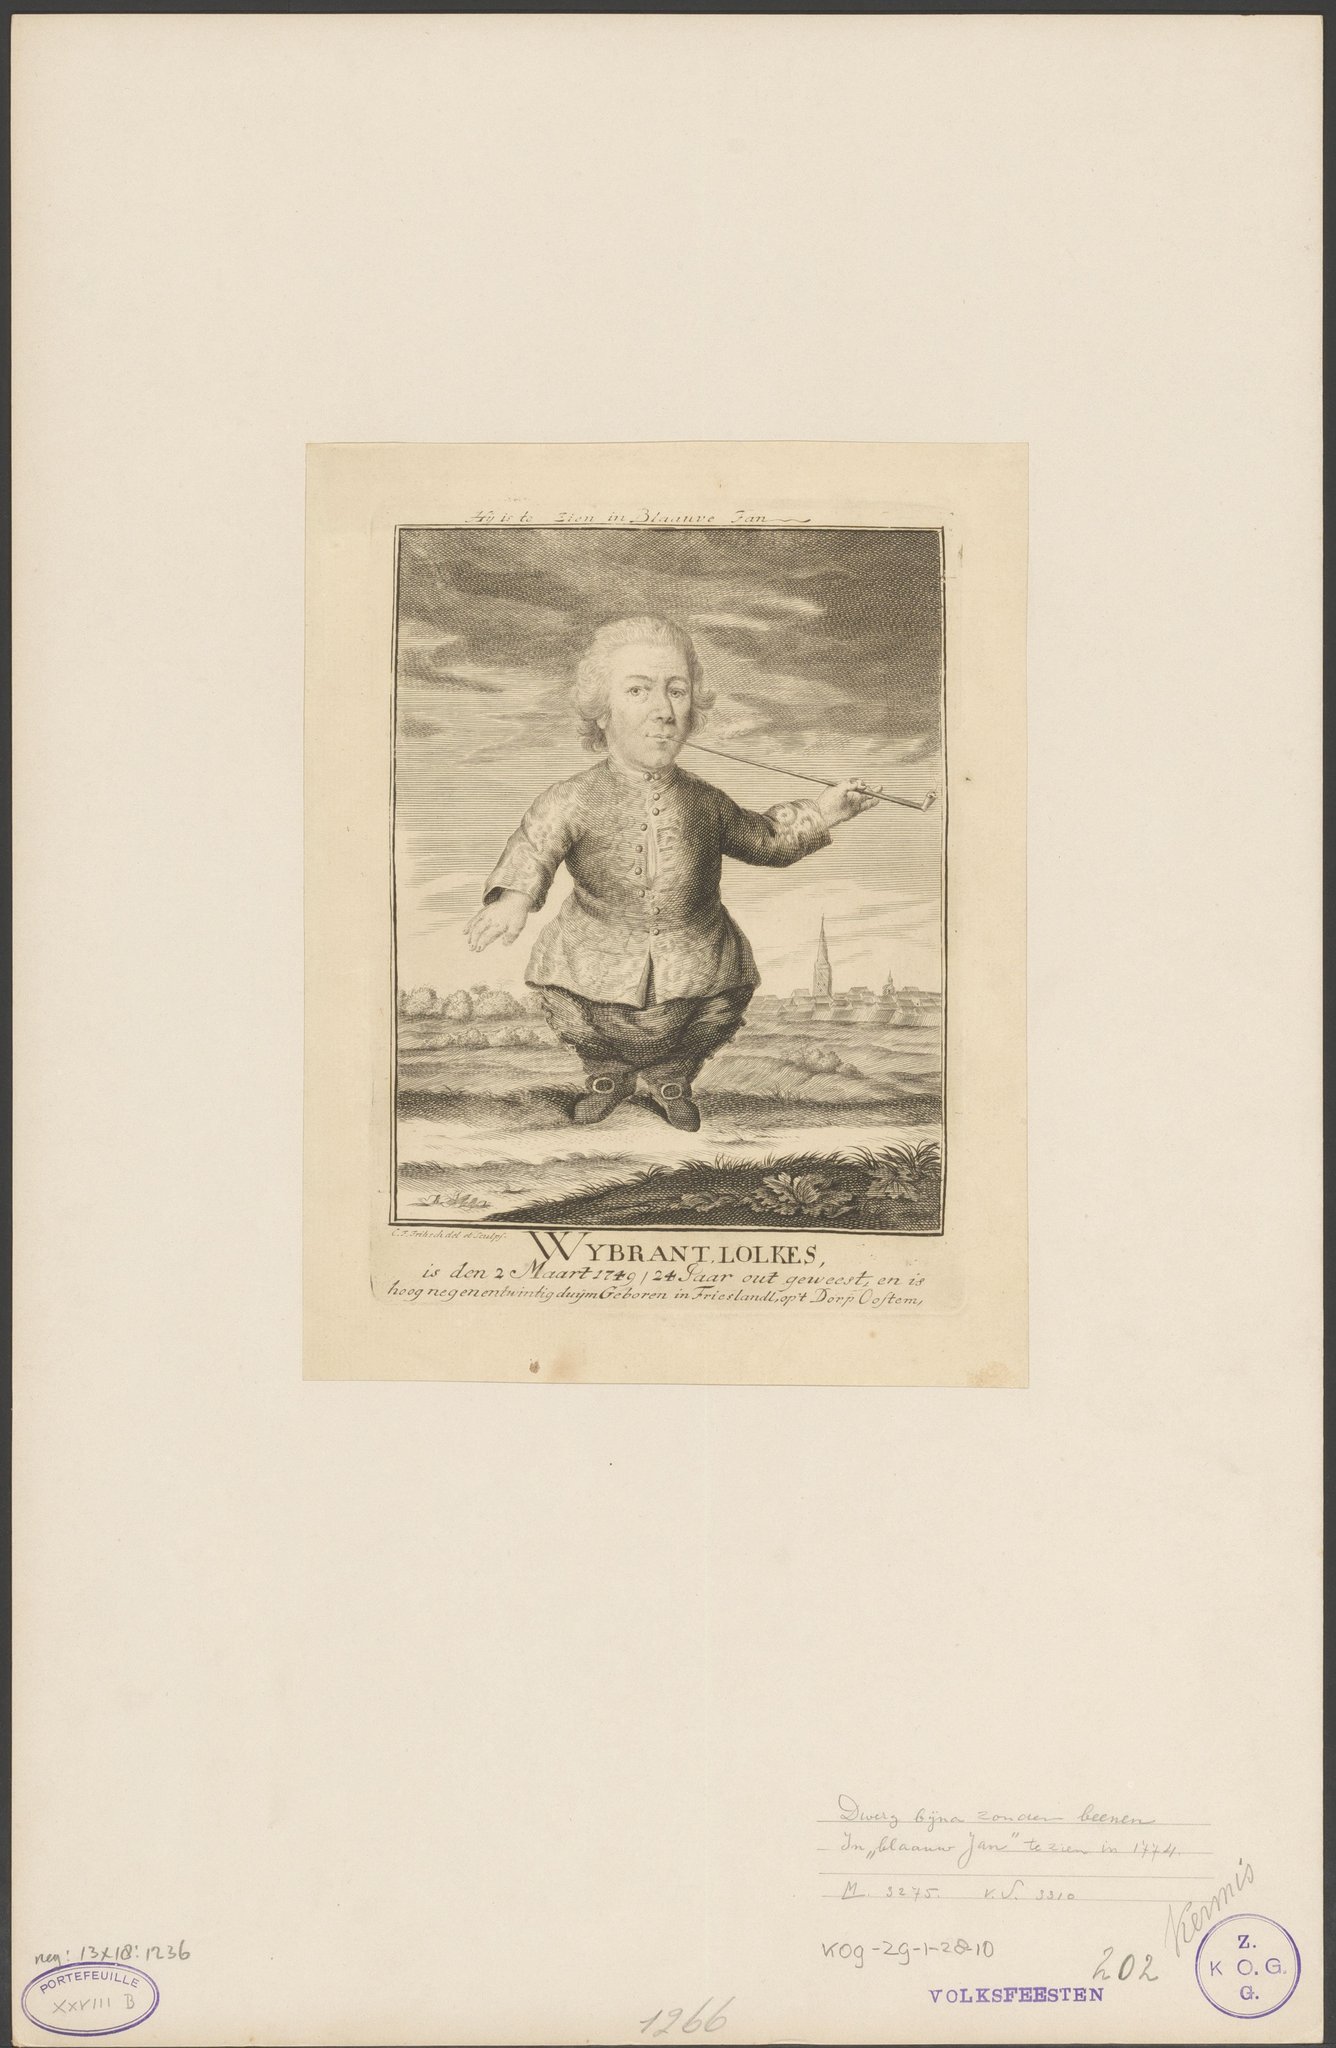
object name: print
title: Wybrant Lolkes met pijp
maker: christian friedrich fritzsch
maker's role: print maker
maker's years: 1719-1774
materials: paper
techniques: engraving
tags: little people, pipe ~ tobacco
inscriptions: collector's mark: Lugt 1641, stamp, stamp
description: Wybrant Lolkes was een klein persoon uit Oostem te Friesland. Hij was 29 duim hoog. In 1749 was hij te zien in de herberg Blaauw Jan op de Kloveniersburgwal. Hij zou hier samen met een lange man liedjes te hebben gezongen. Onderwerpsrubrieken binnen de Atlas Zeden en Gewoonten: Zeden en Gewoonten in Engeren Zin. Volksleven. Volksfeesten. Kermistypen, wondermenschen en dergelijken.